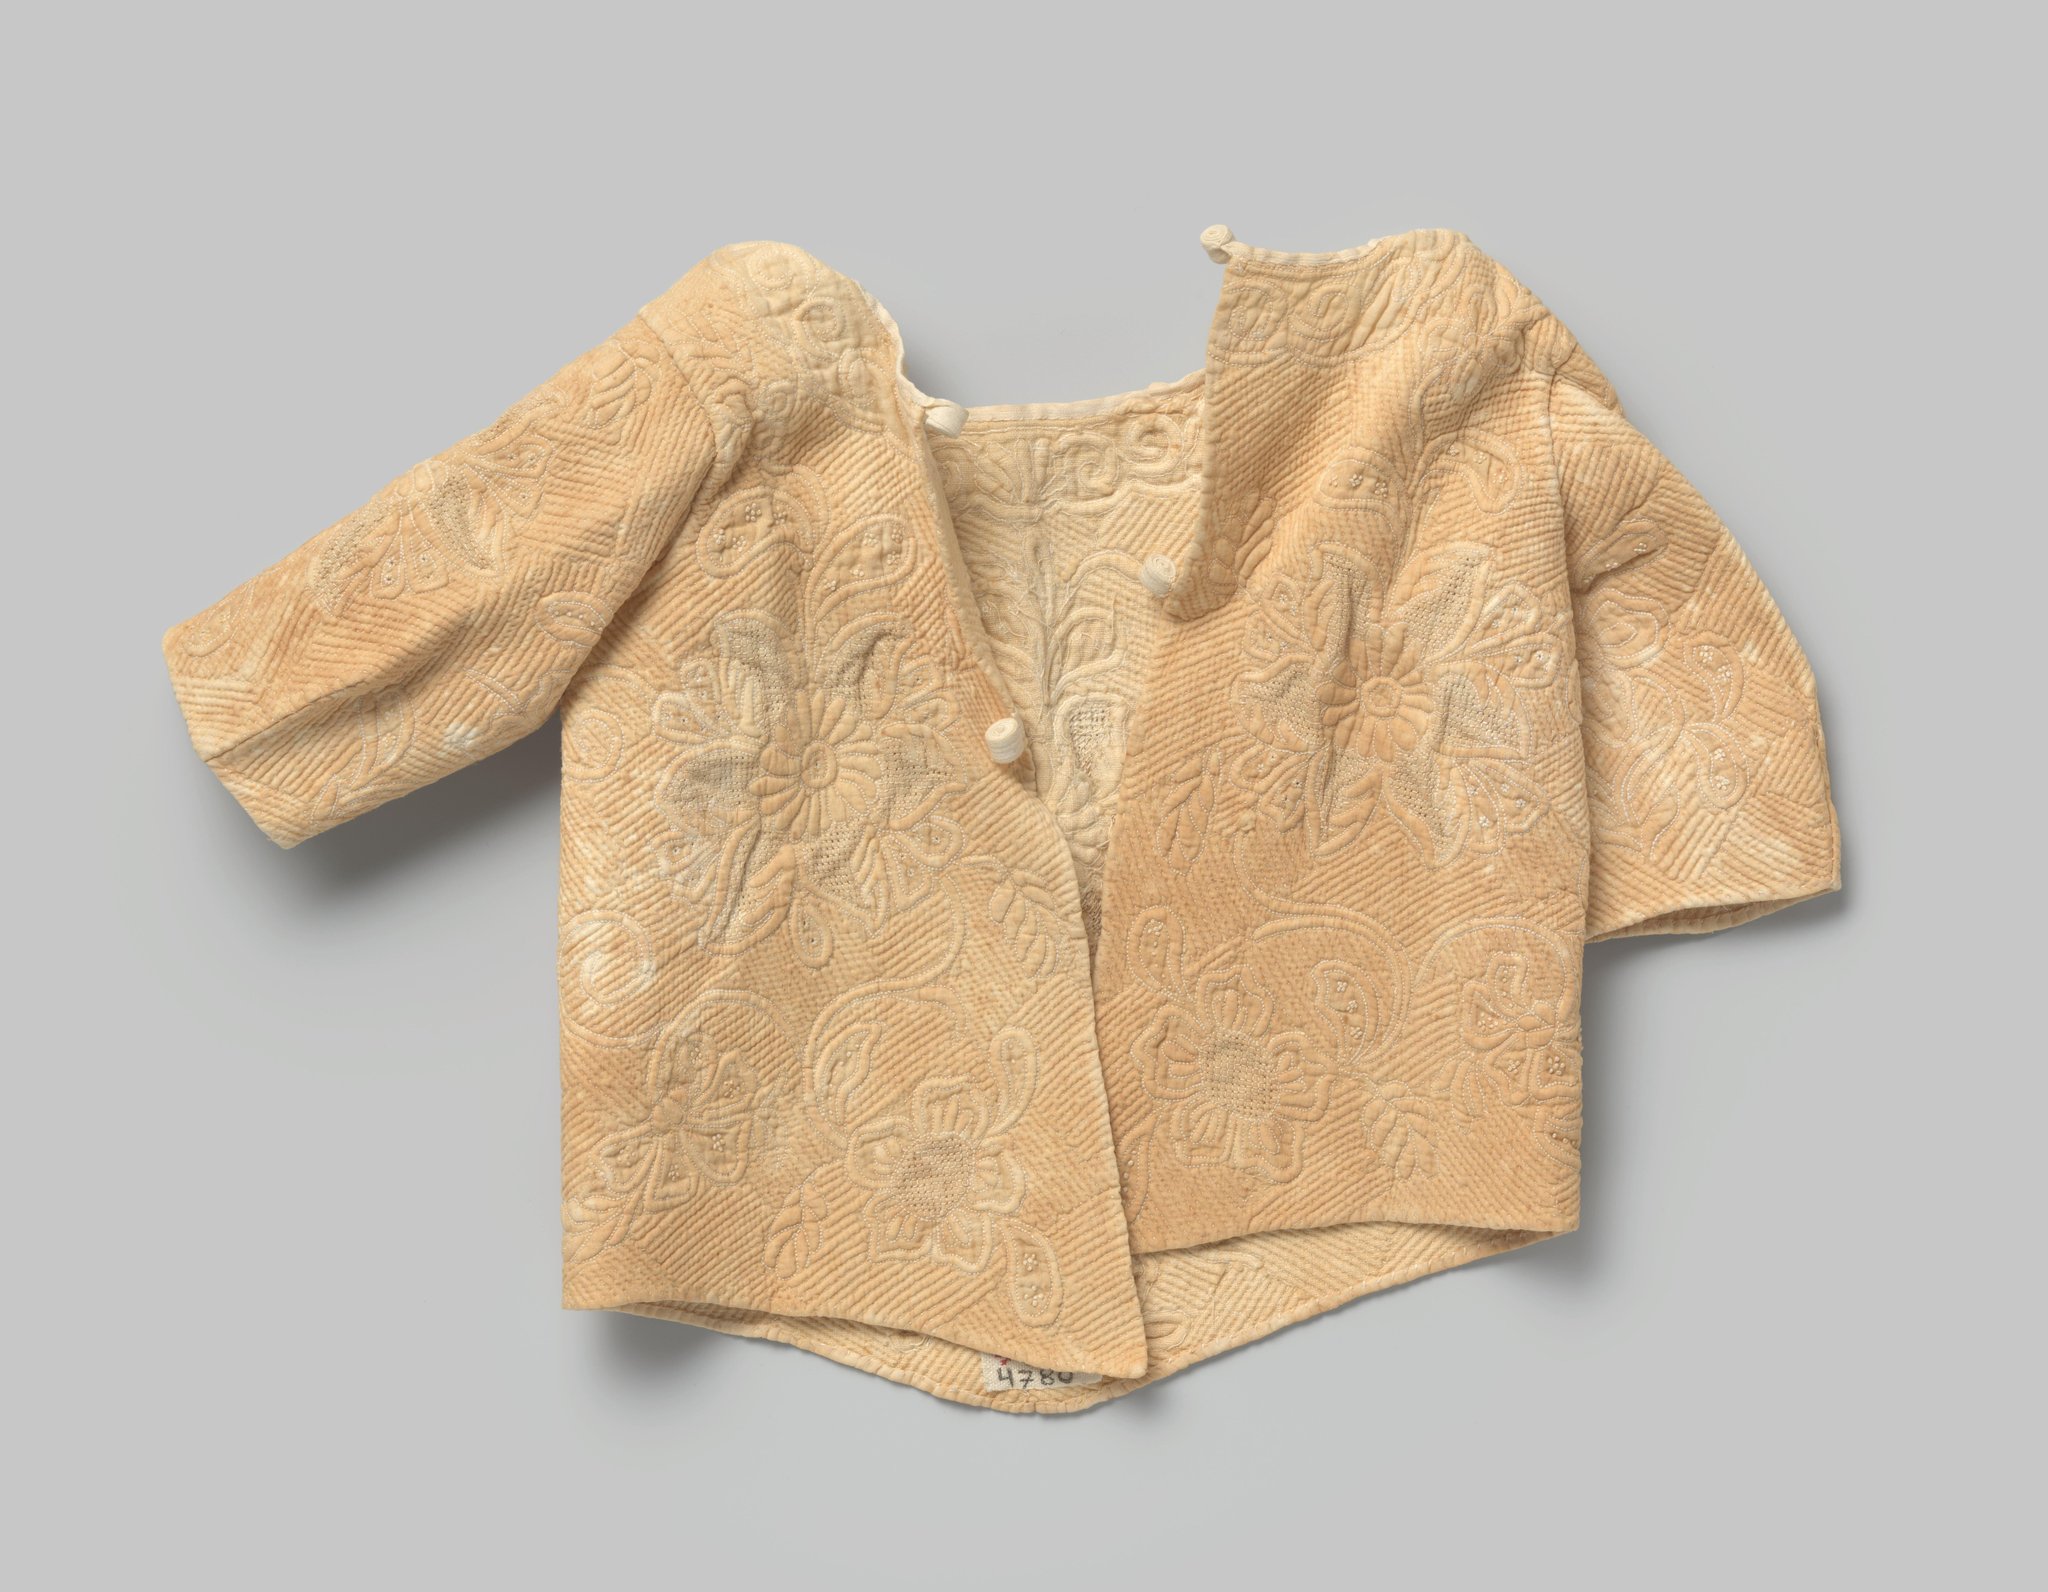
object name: borstrok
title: Borstrok met Zaans stikwerk met enkele open steken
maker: Anonymous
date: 1700-1800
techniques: embroidered, quilting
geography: neder-over-heembeek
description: Borstrok met Zaans stikwerk met enkele open steken.